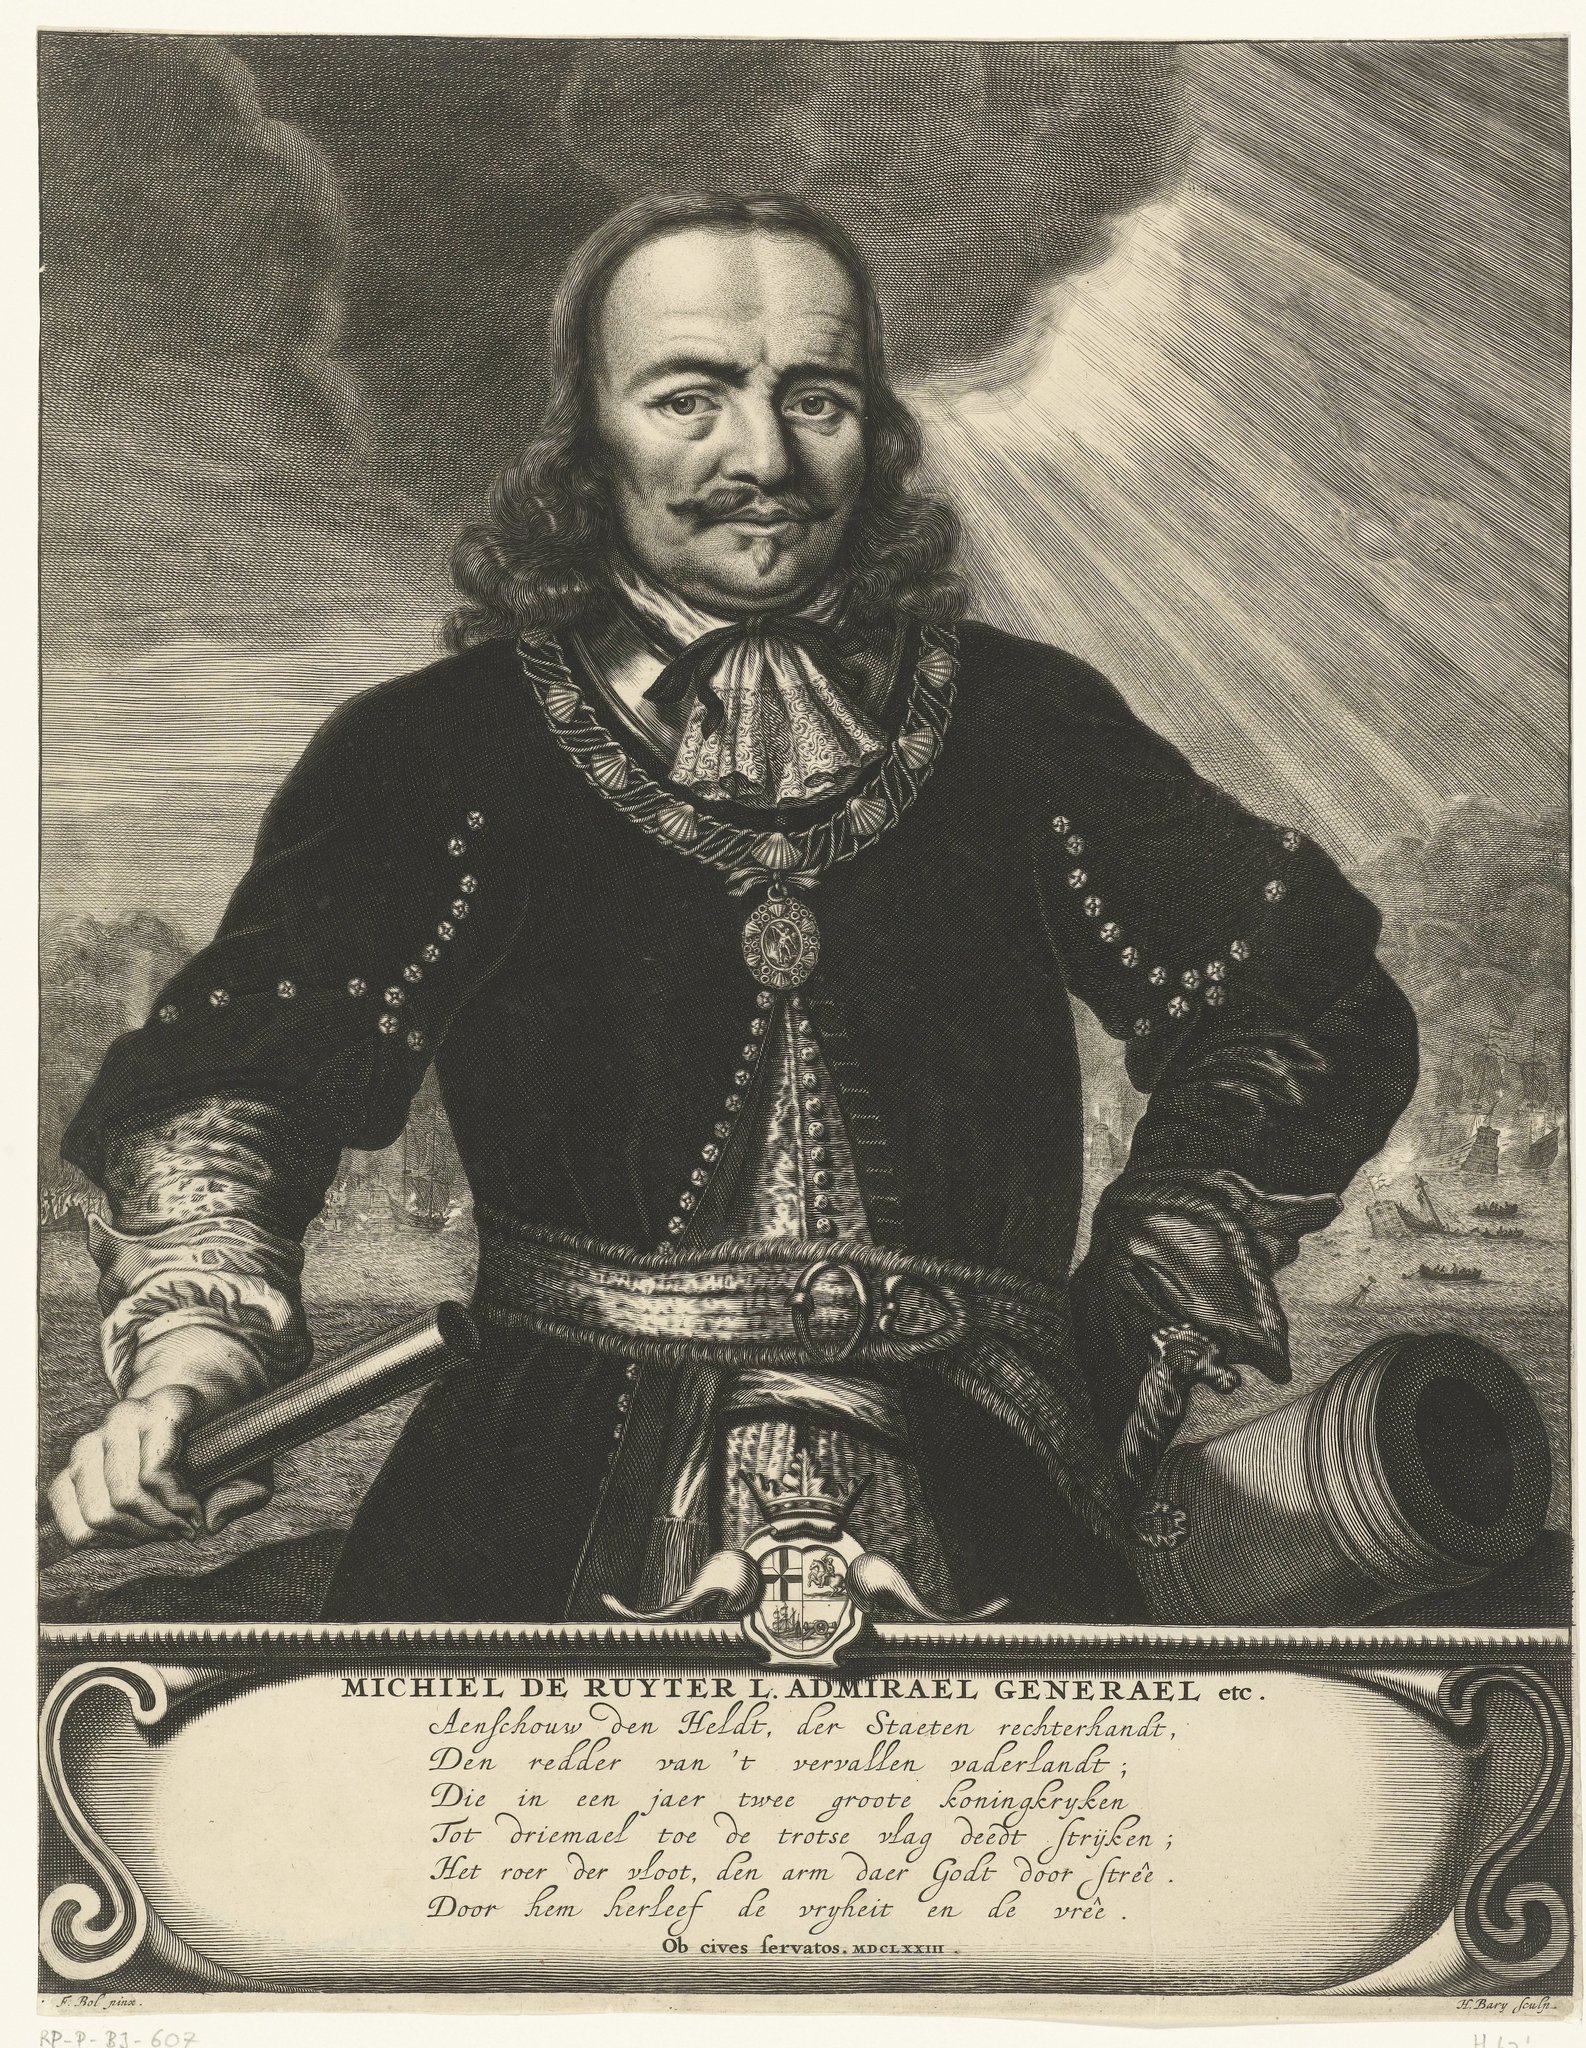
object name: print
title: Portret van Michiel Adriaenszoon de Ruyter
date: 1673-1707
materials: paper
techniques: engraving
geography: netherlands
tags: flushing, michiel adriaenszoon de ruyter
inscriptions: collector's mark: Lugt 2228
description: Portret van admiraal Michiel Adriaenszoon de Ruyter met de commandostaf in zijn hand. Hij draagt een keten met de Orde van Sint-Michiel. Op de achtergrond een zeegevecht. Onder het portret een lofdicht van zes regels in het Nederlands.